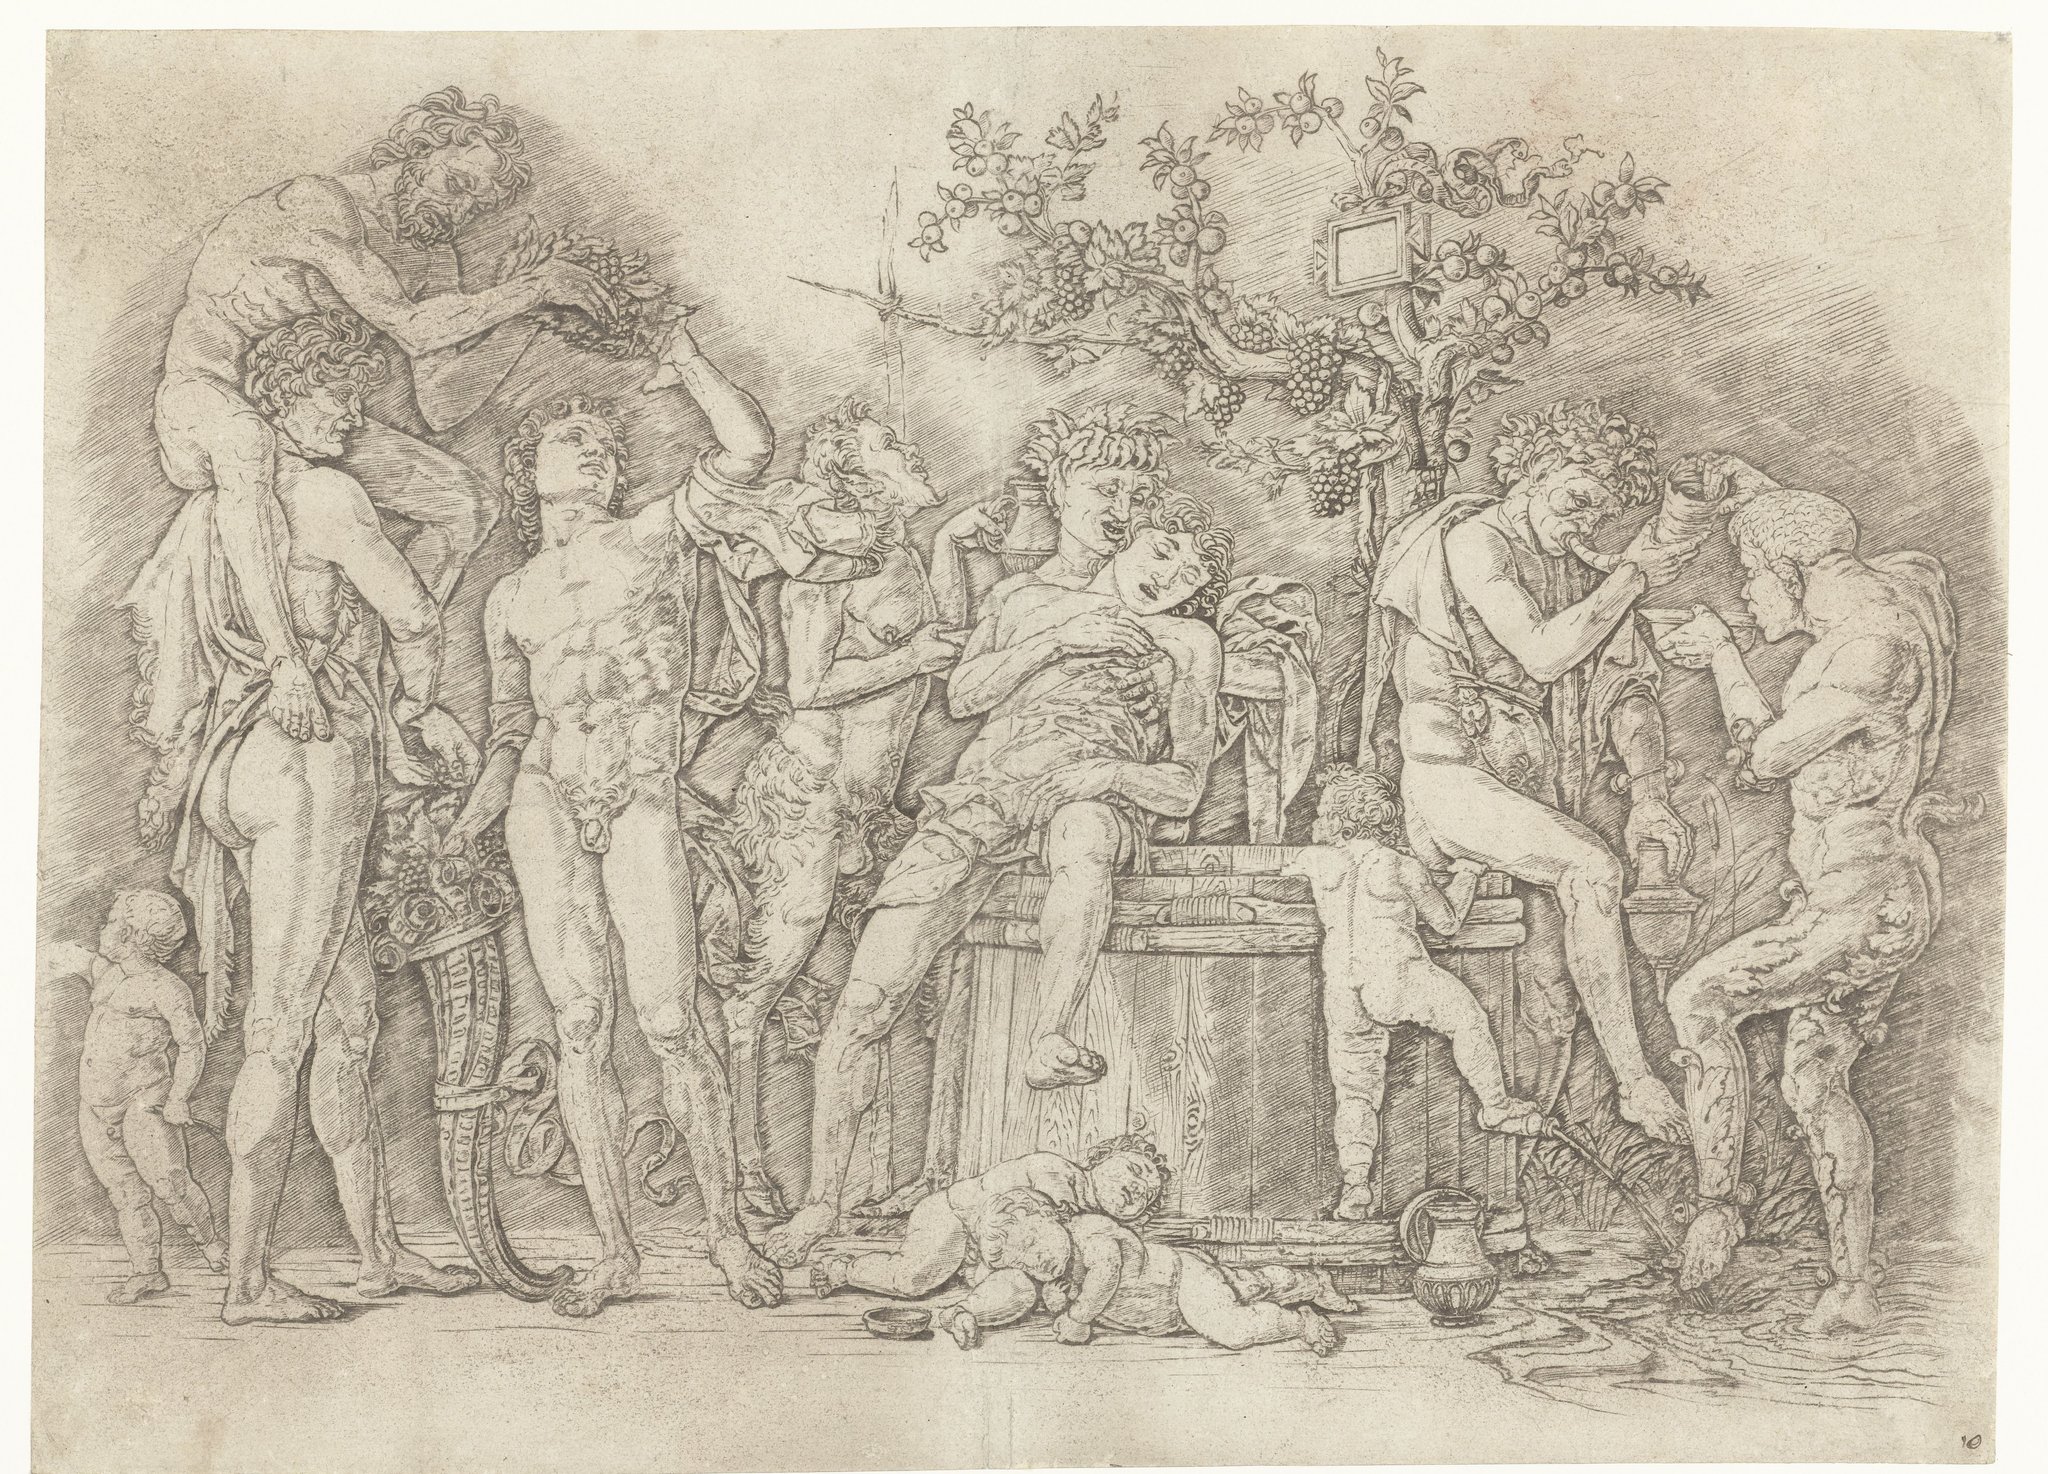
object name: print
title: Bacchanaal met satyrs en bacchanten bij wijnpers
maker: andrea mantegna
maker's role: print maker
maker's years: 1431-1506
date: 1473-1477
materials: paper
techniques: printing, engraving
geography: italy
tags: thiasos, i.e. bacchus' revel-rout, bacchanal without bacchus, wine-press